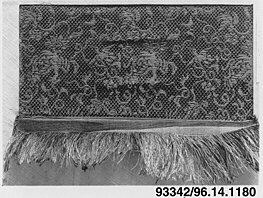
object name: piece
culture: japanese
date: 1701-1900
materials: silk